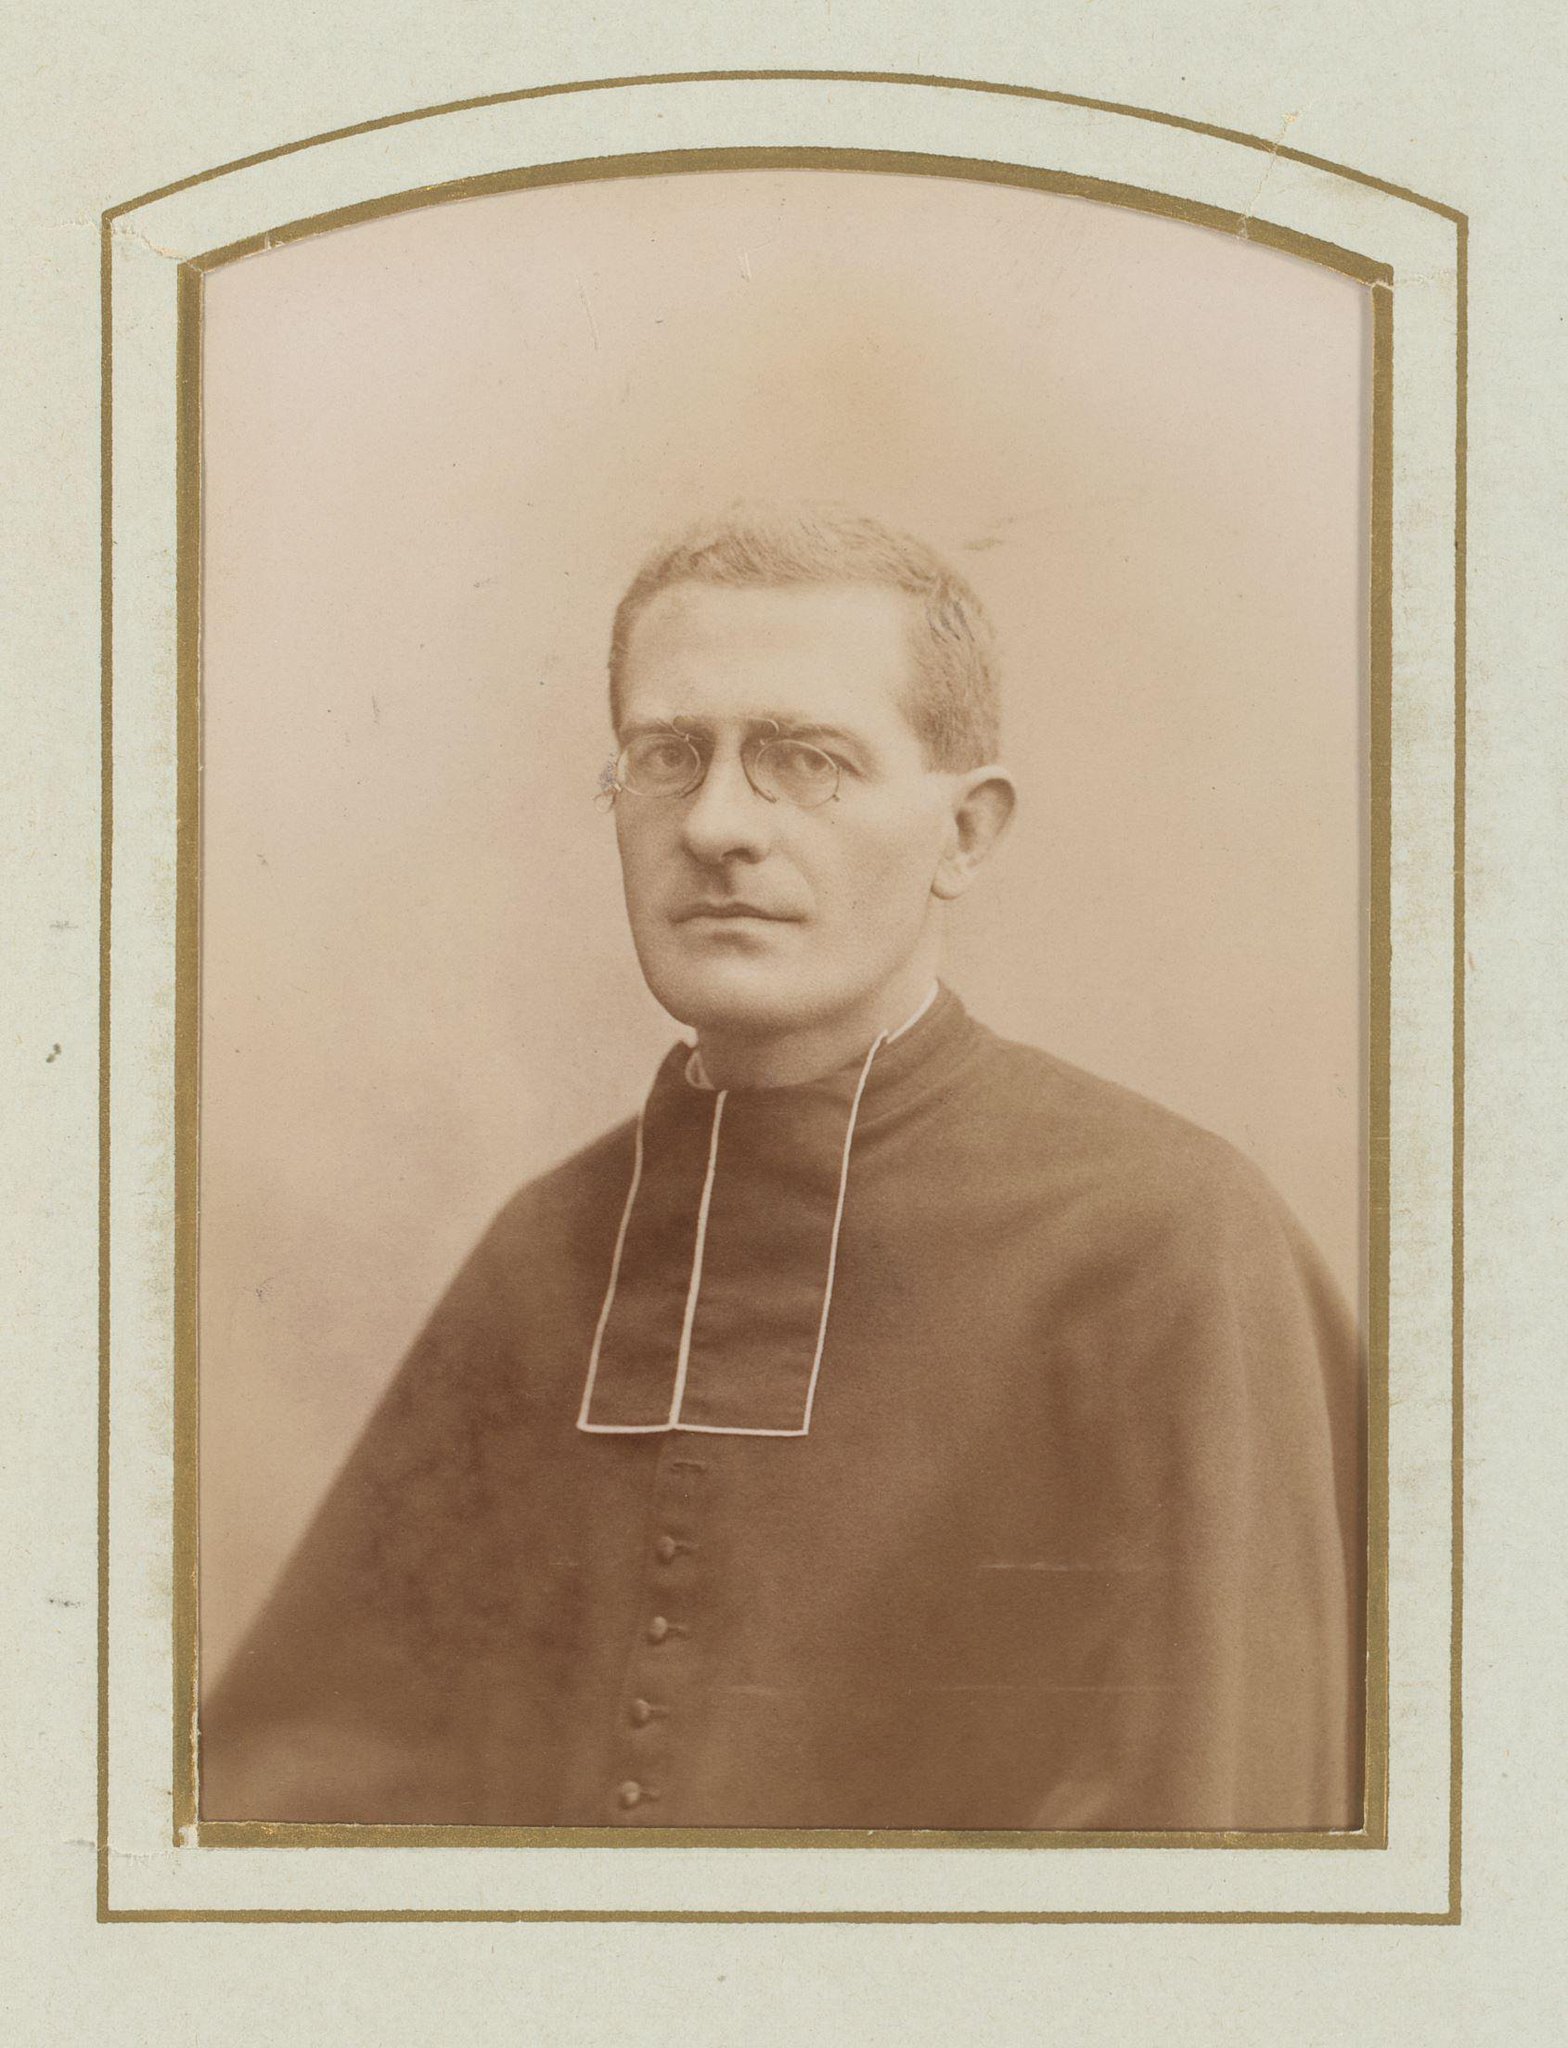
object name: cabinet photograph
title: Portret van een man met bril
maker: eugène pirou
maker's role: fotograaf, fotostudio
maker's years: 1841-1909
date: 1880-1904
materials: cardboard, photographic support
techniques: collodion silver print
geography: paris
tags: eyeglasses, spectacles, historical persons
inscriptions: inscription: ‘Eug. PIROU/ PHOTOGRAPHE/ 5, Boulevard Saint-Germain, 5/ HOTEL PRIVÉ/ TÉLÉPHONE/ 10 MÉDAILLES D'OR 1885-1889/ 2 DIPLOMES D'HONNEUR/ 1887 - 1890/ HORS CONCOURS/ Membre du Jury Supérieur 1892 - 93’